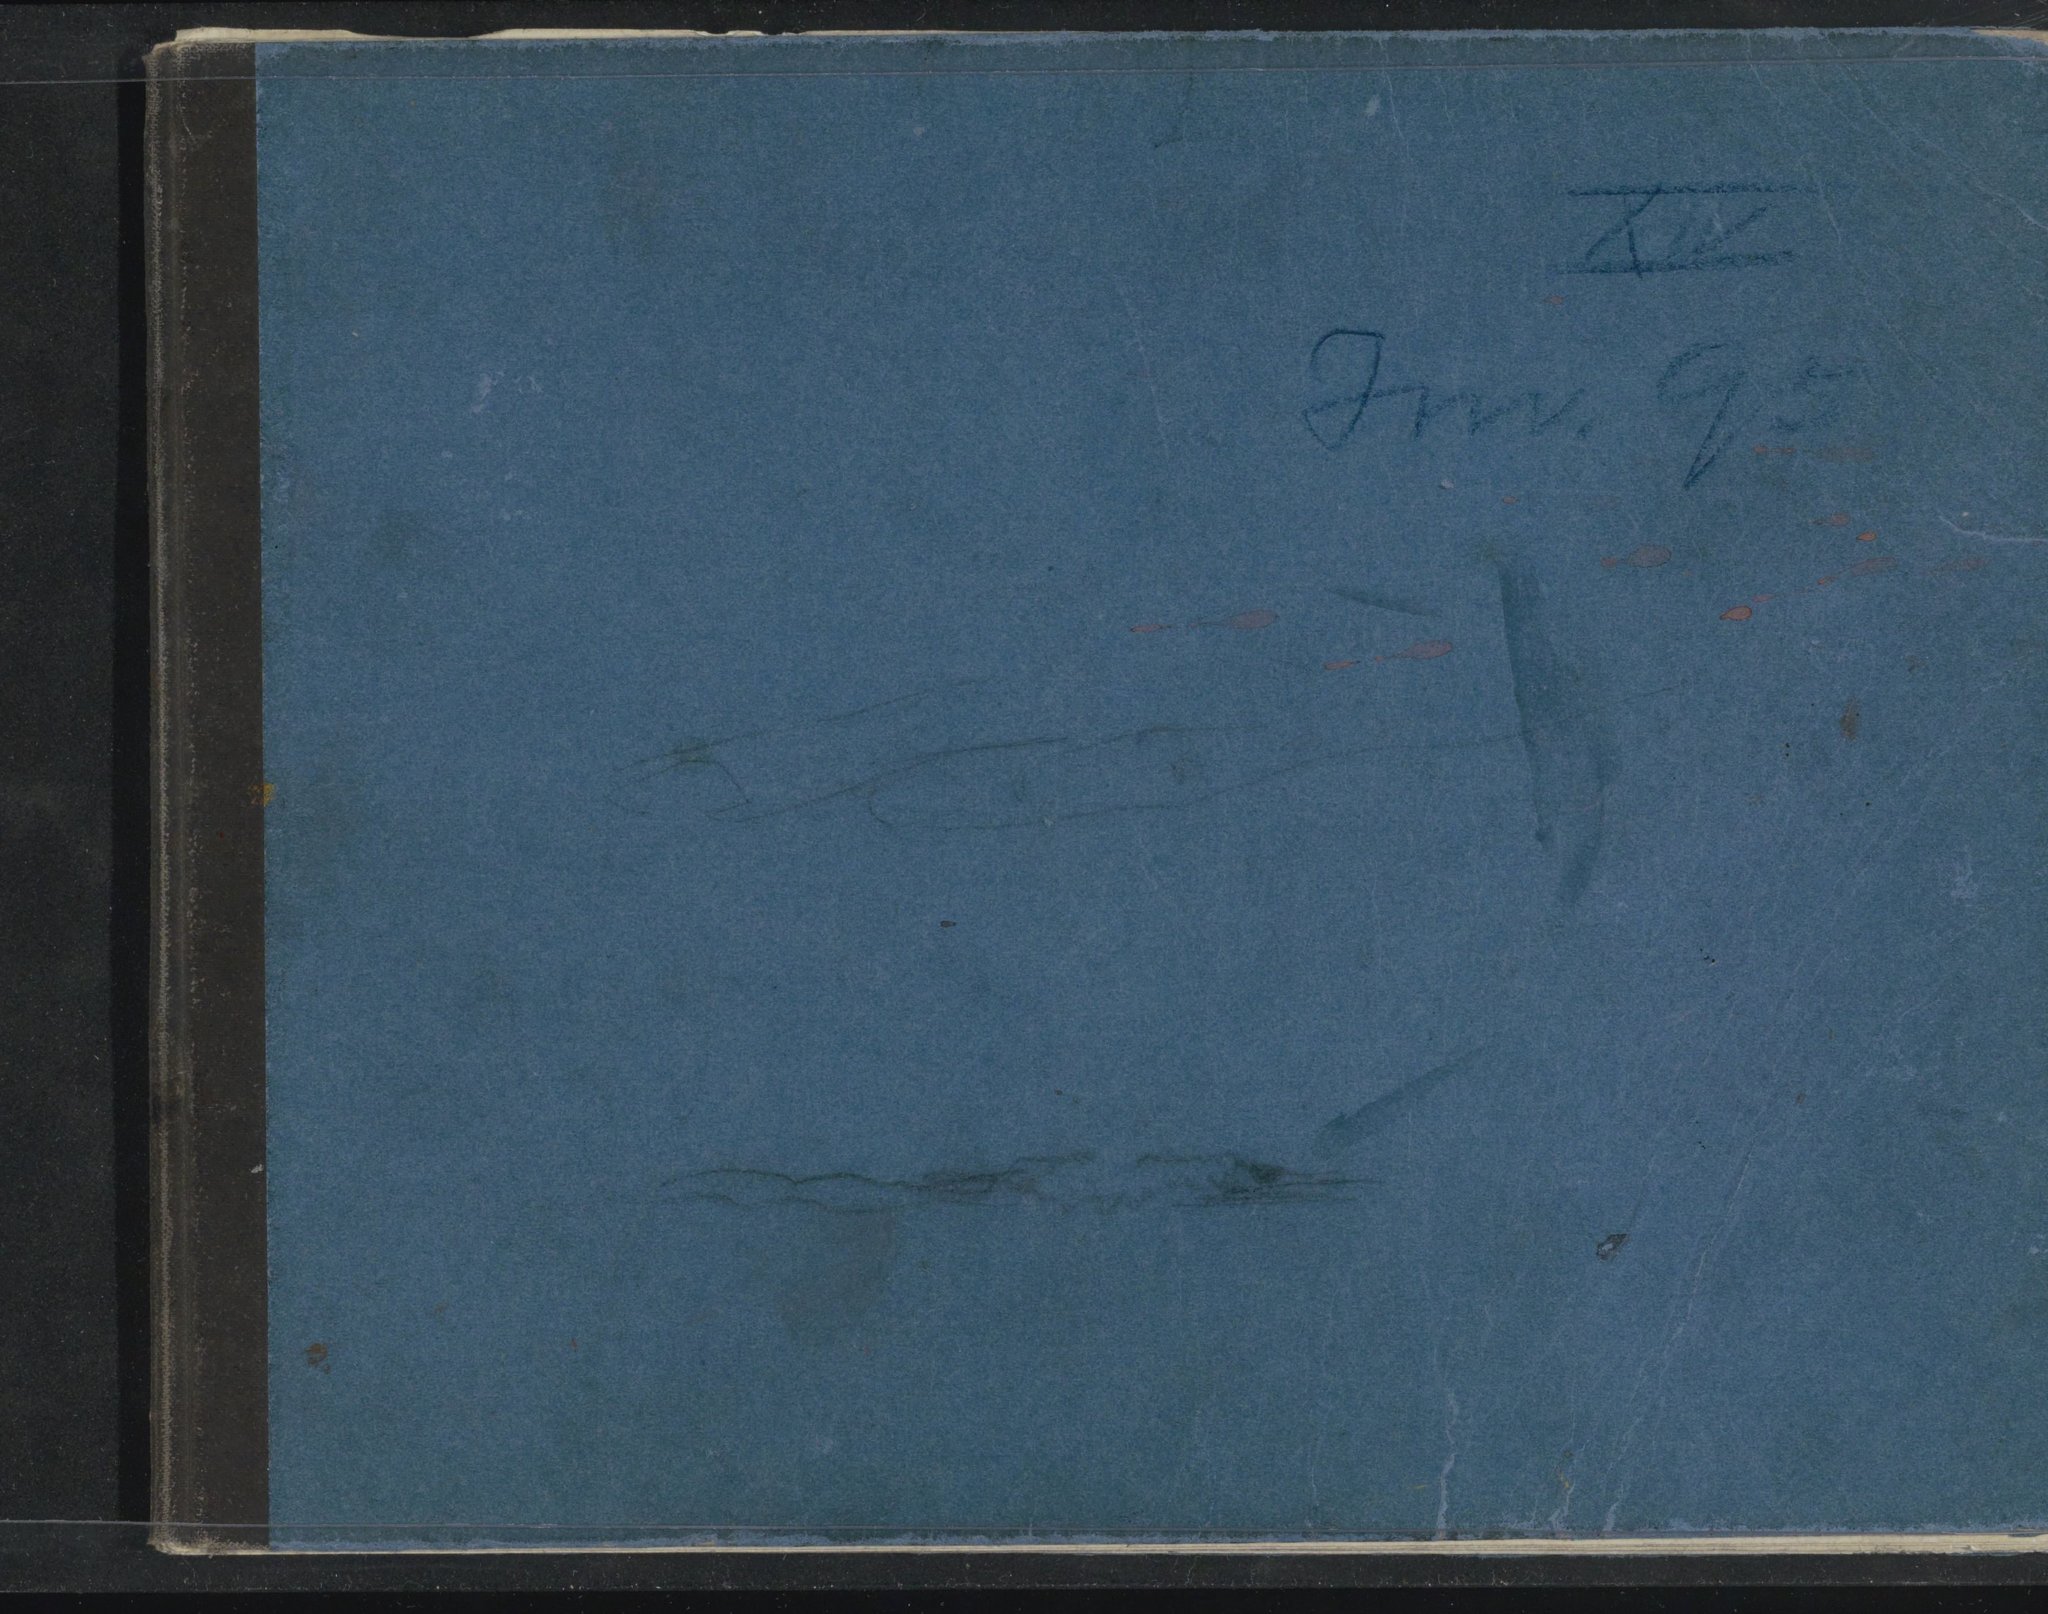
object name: sketchbook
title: Schetsboek XIV met 17 bladen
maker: isaac israels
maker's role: draughtsman, painter, print maker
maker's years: 1865-1934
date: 1875-1934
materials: cardboard, chalk, linen, paper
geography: the hague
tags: circus, the audience ~ art performance, in or beside the water (on the beach)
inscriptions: collector's mark: Lugt 2228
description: Schetsboek nr. XIV bestaande uit 17 bladen met onder andere vrouwen, naakten, portretten en strandscènes.